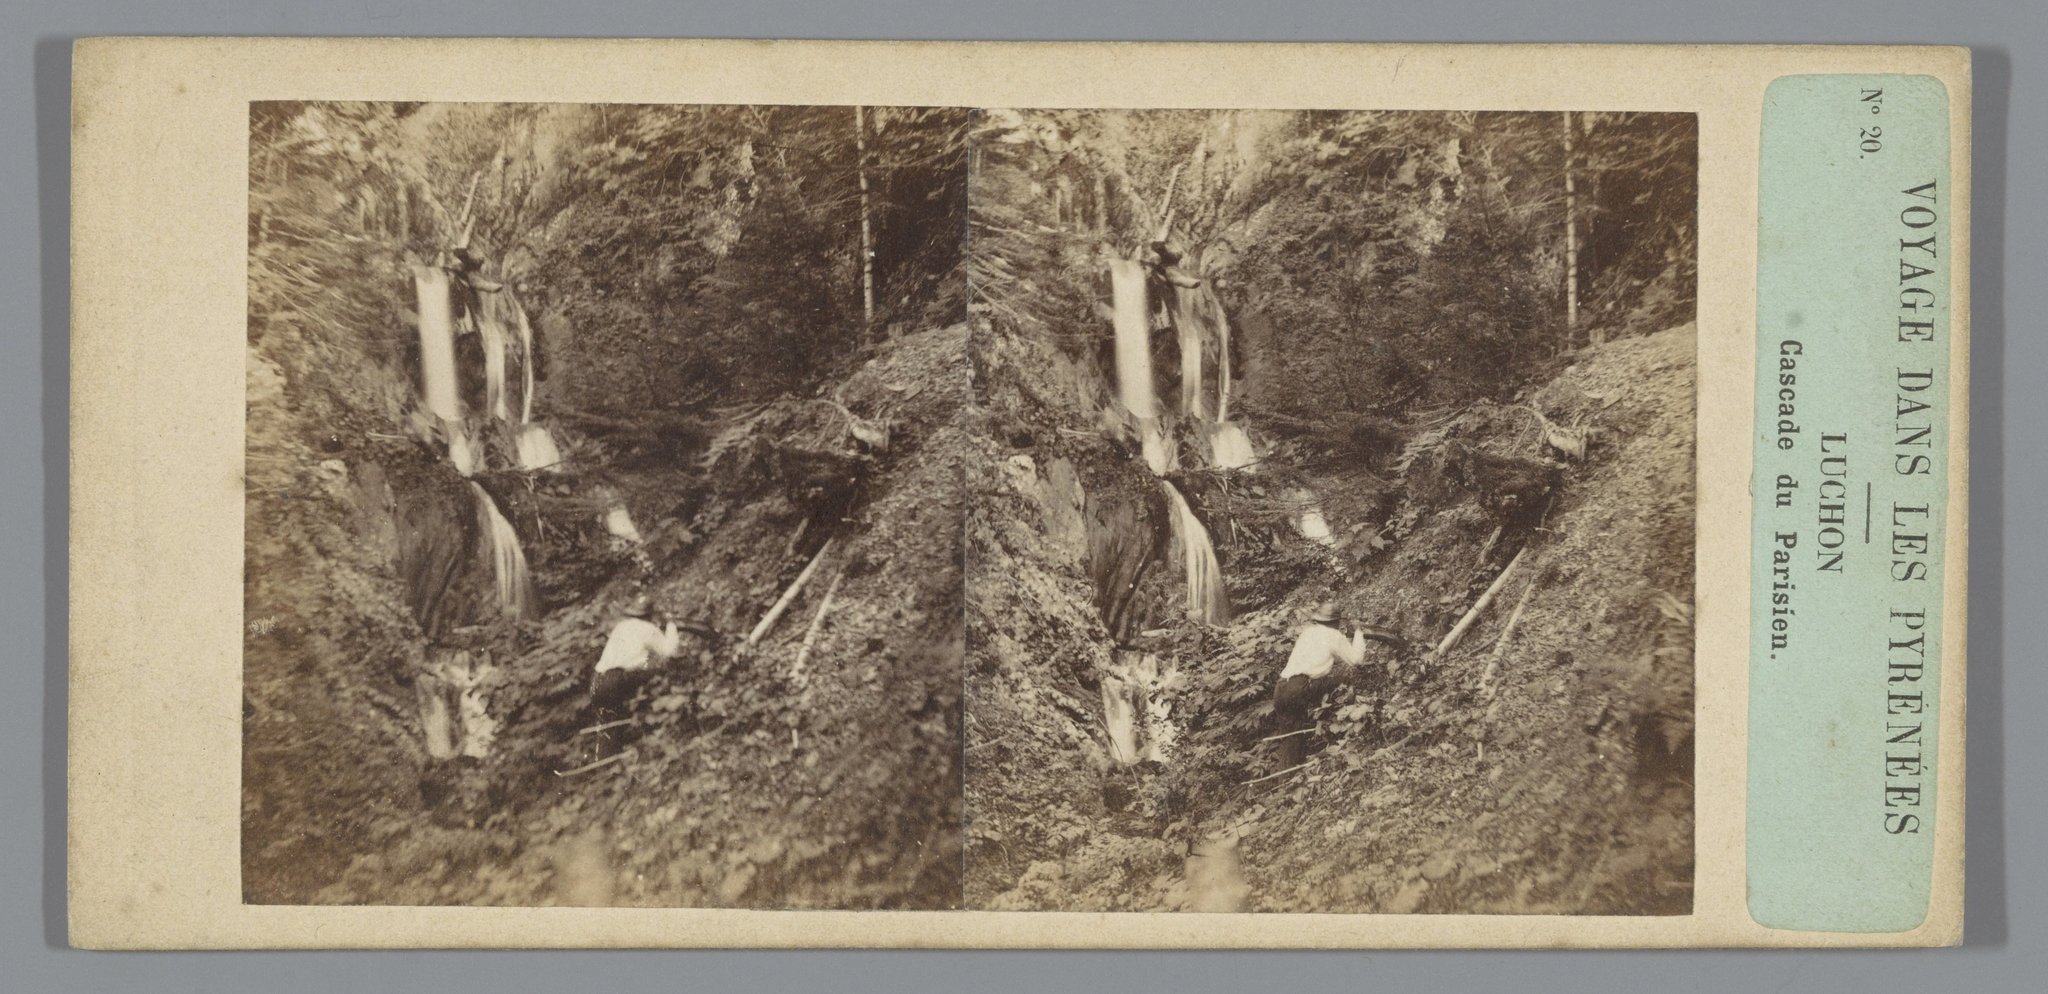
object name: stereograph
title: Luchon, Cascade du Parisien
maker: charles paul furne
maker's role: publisher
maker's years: 1824-1875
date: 1860-1880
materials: cardboard, photographic support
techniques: albumen print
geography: pyrenees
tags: waterfall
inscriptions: number: ‘No 20.’